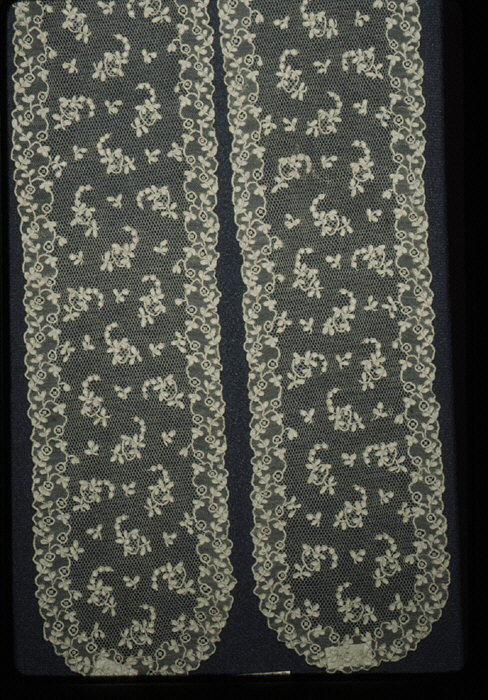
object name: lappet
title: Lappet (one of a pair)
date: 1767-1800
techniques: lace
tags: flowers